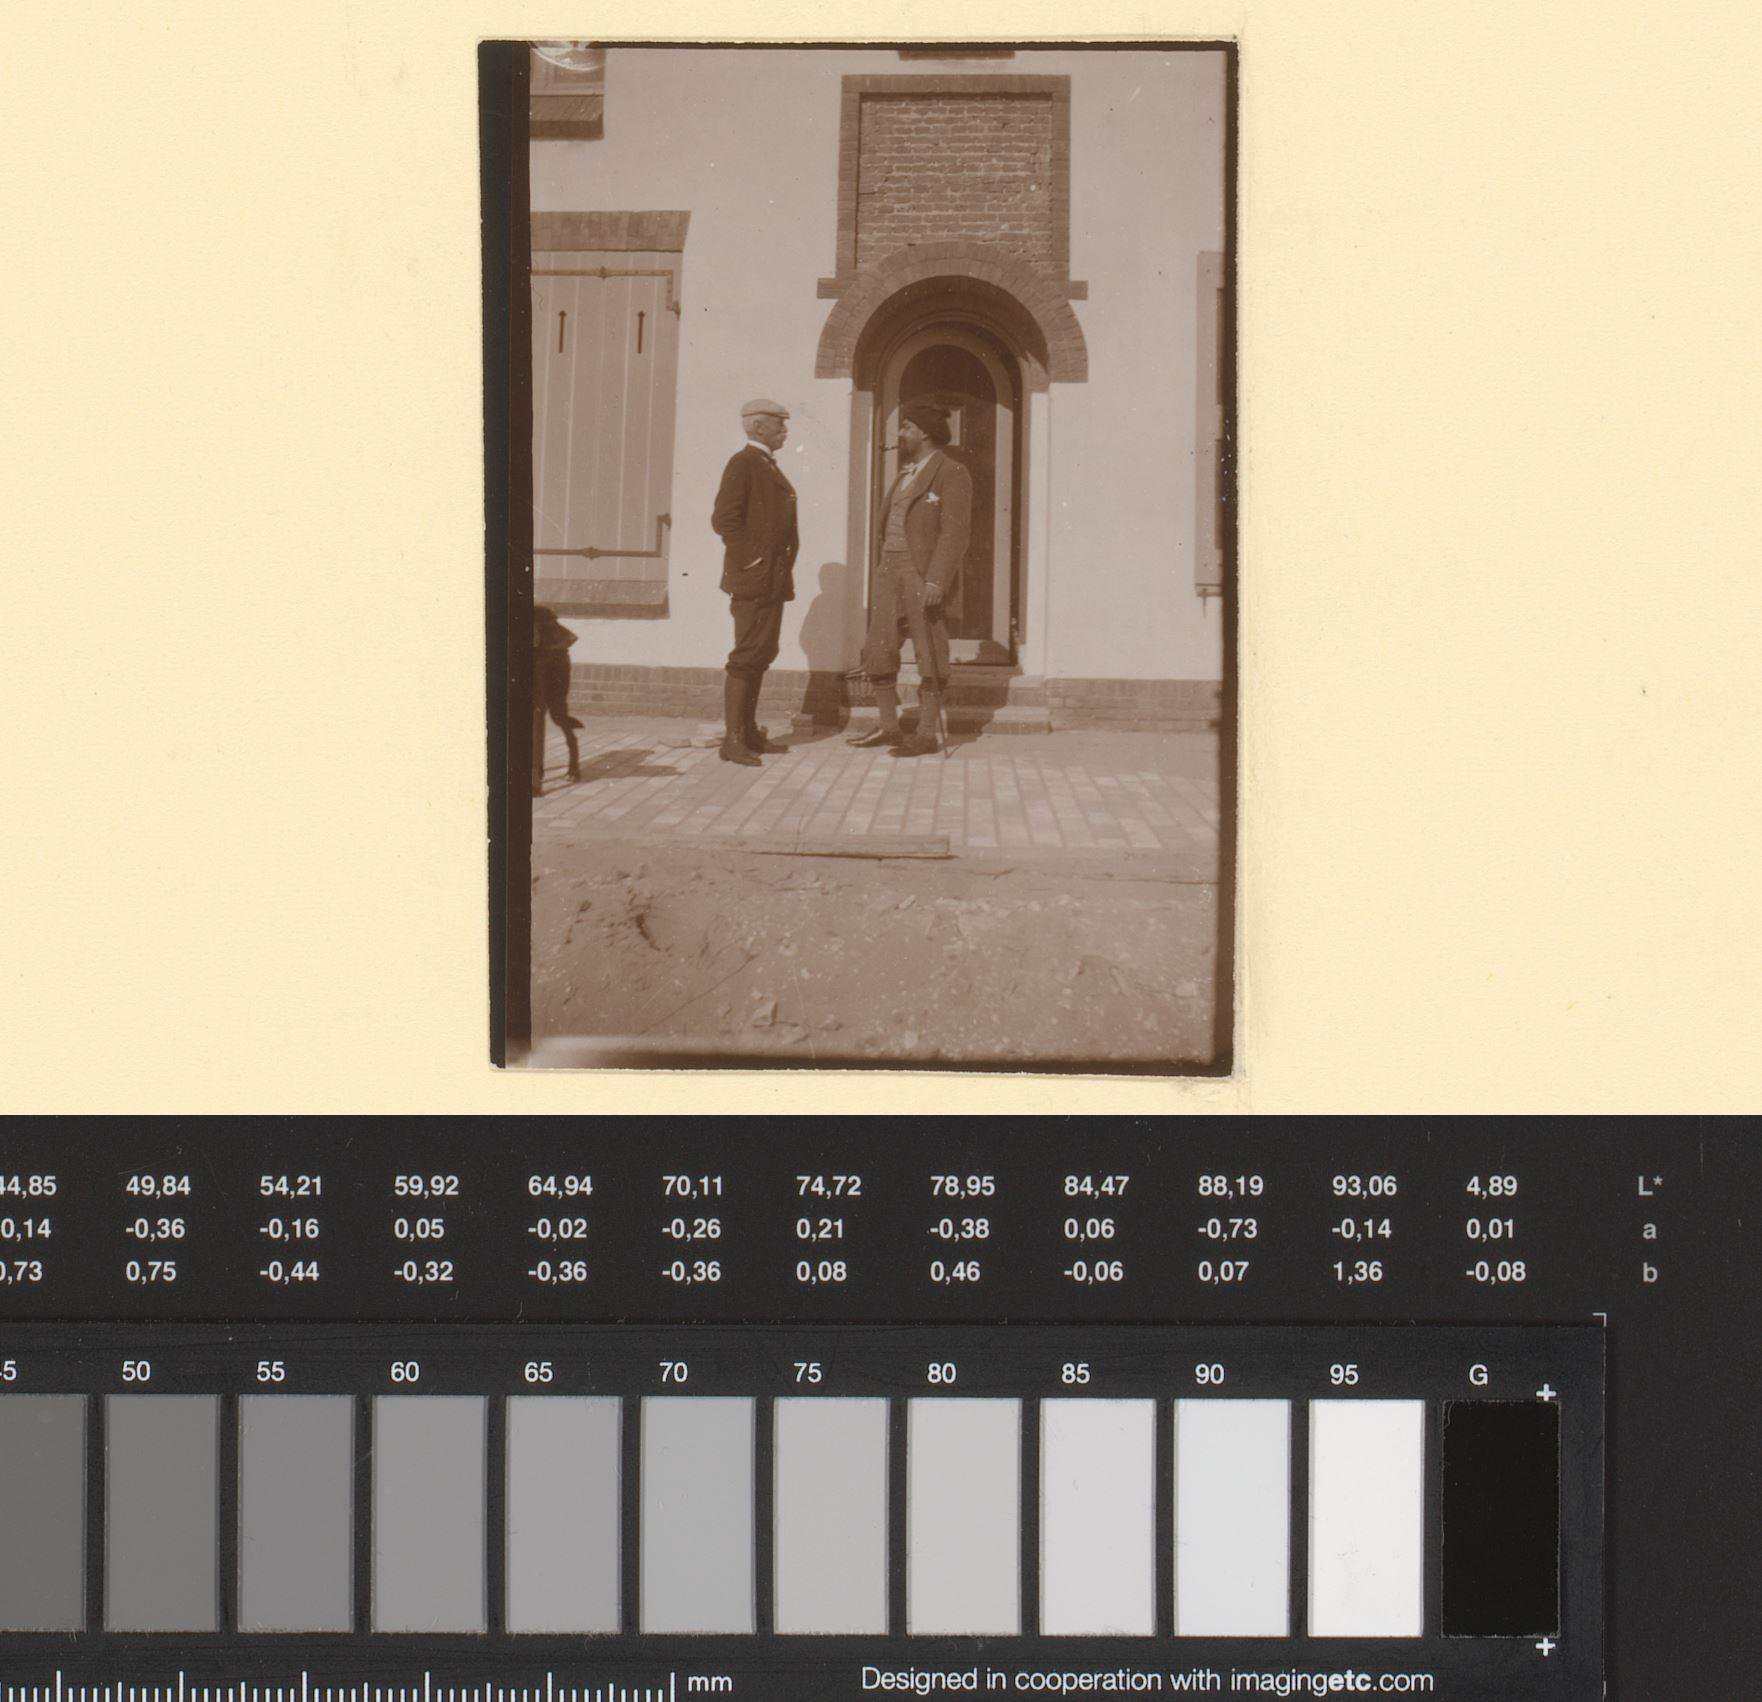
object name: photograph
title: Carel Nicolaas Storm van 's-Gravesande en Jan Toorop voor een huis in Katwijk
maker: Anonymous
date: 1809-1899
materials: paper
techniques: collodion silver print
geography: katwijk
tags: carel nicolaas storm van 's-gravesande, the hague, painter, print maker, draughtsman, jan toorop, historical persons, conversation, dialogue; conversation piece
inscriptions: inscription: ‘Storm v 's Gravesande/ (rechts)’